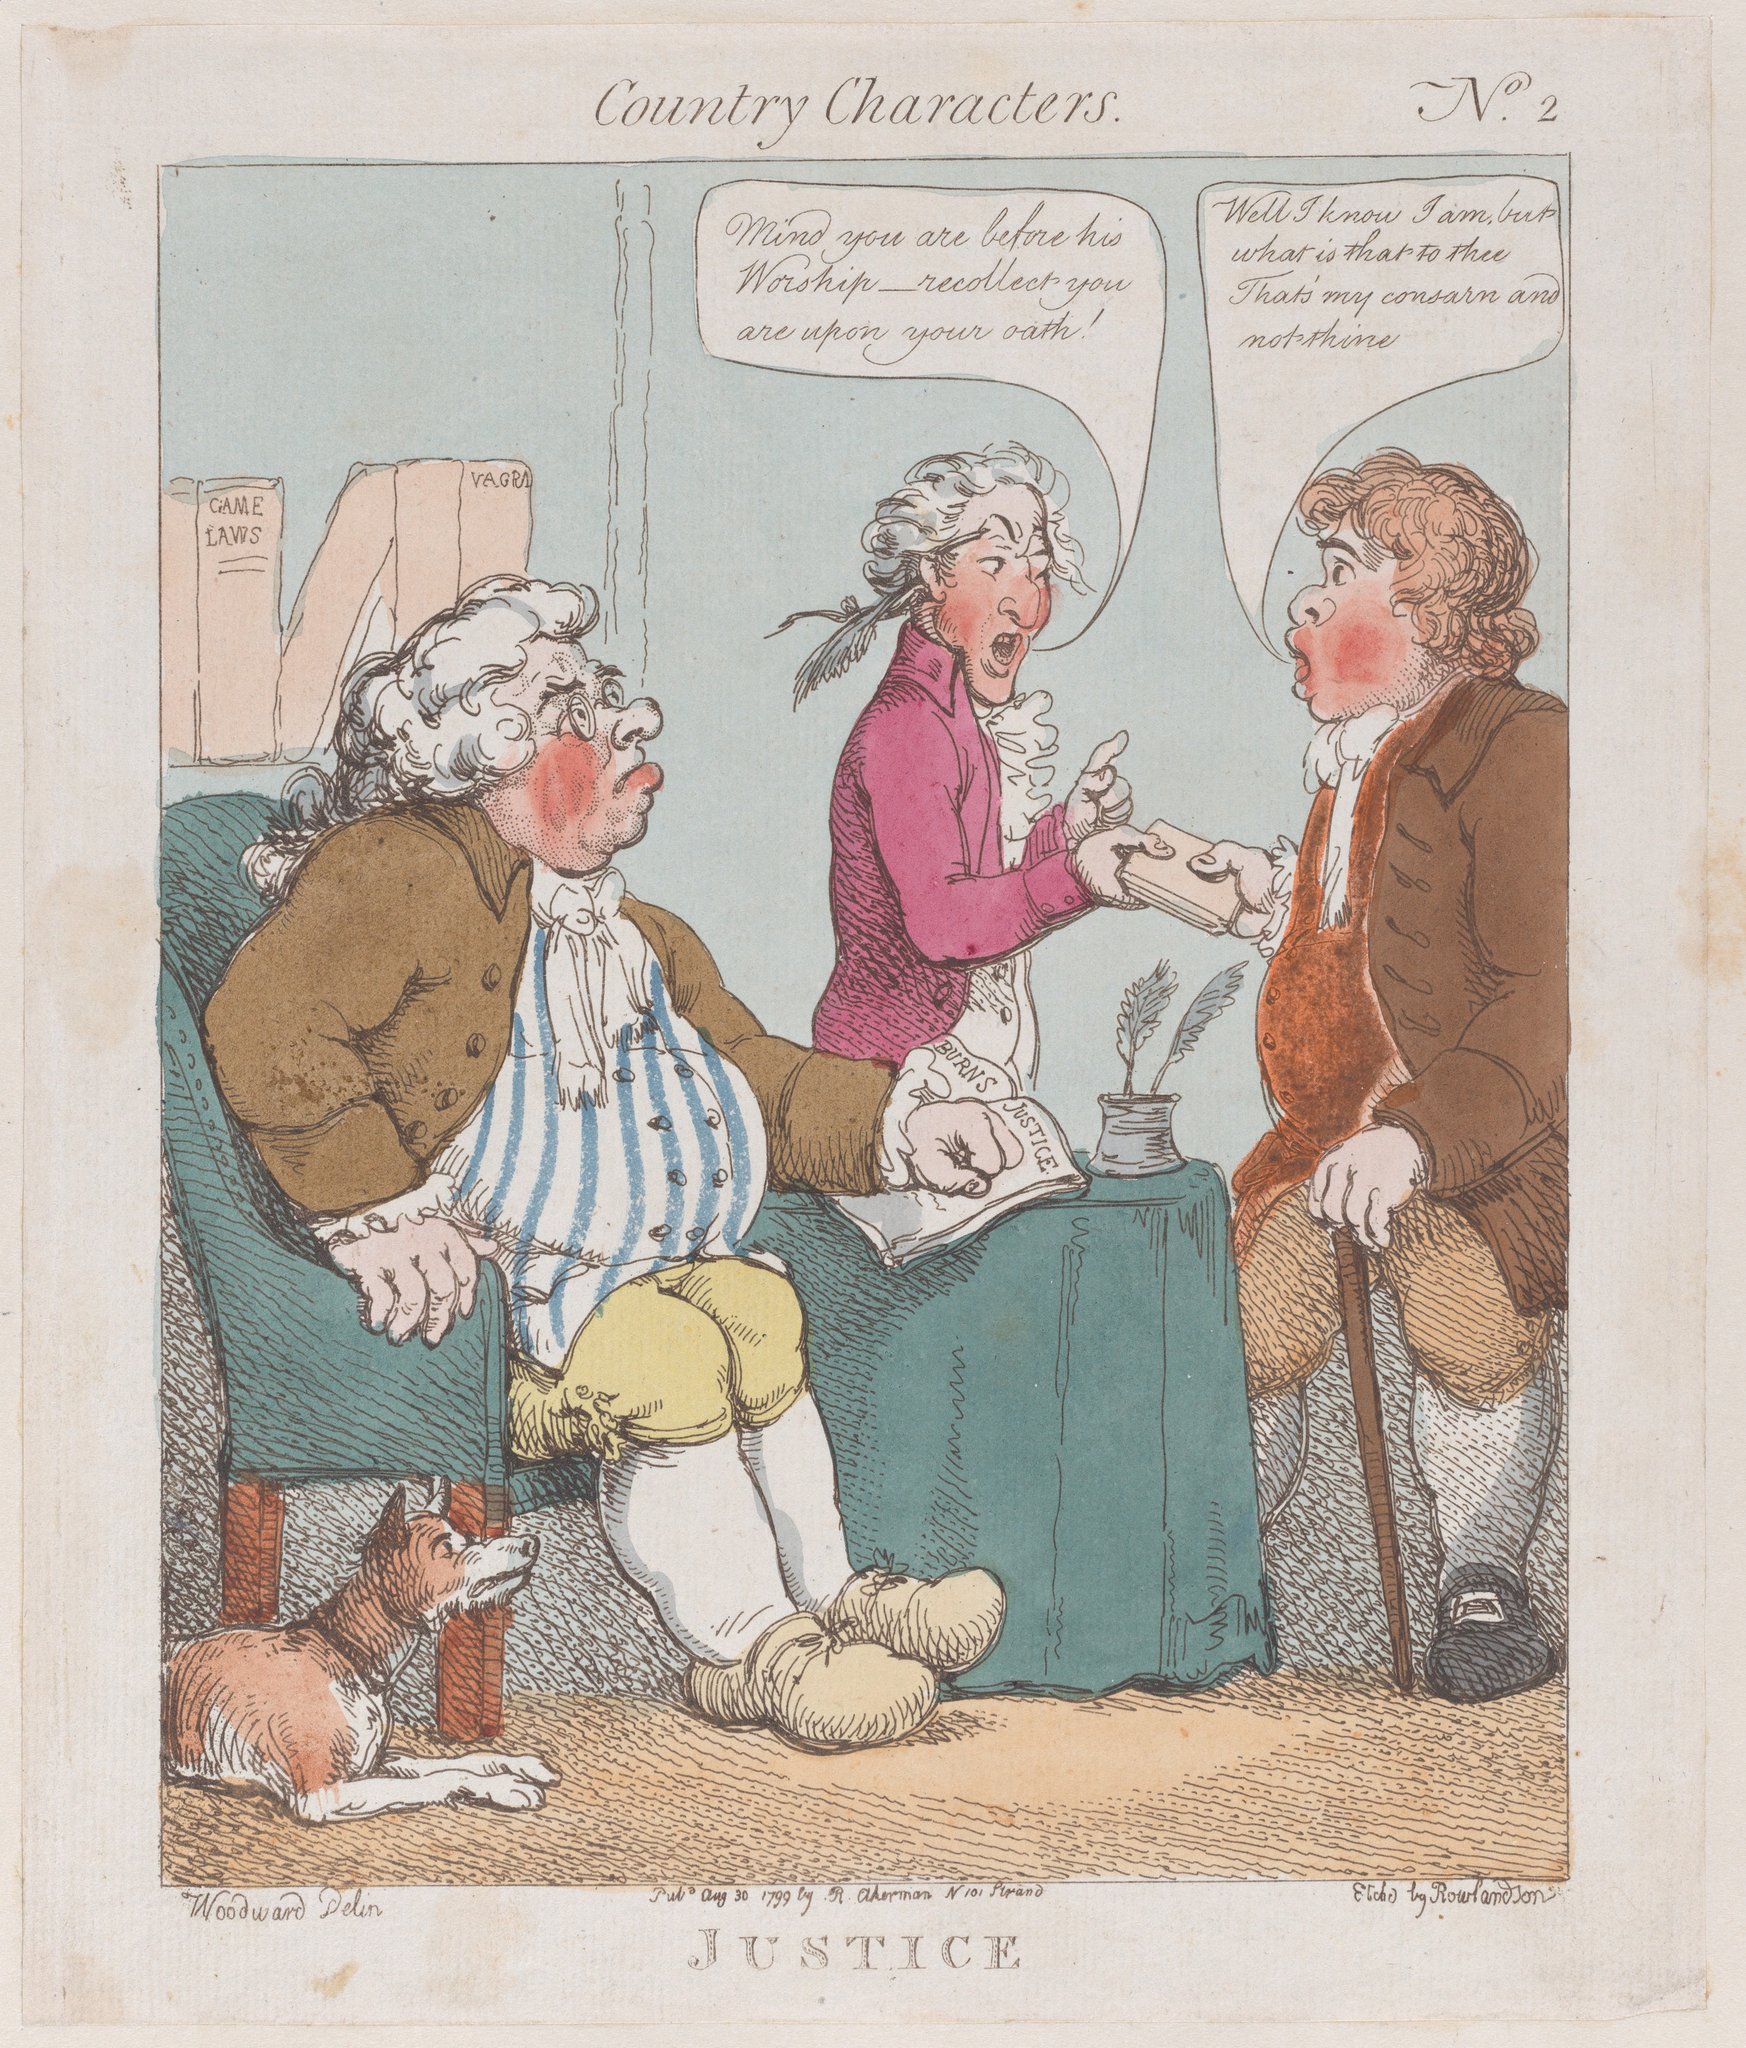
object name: print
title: Justice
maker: thomas rowlandson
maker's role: artist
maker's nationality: british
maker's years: 1757-1827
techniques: etching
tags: satire,men,dogs